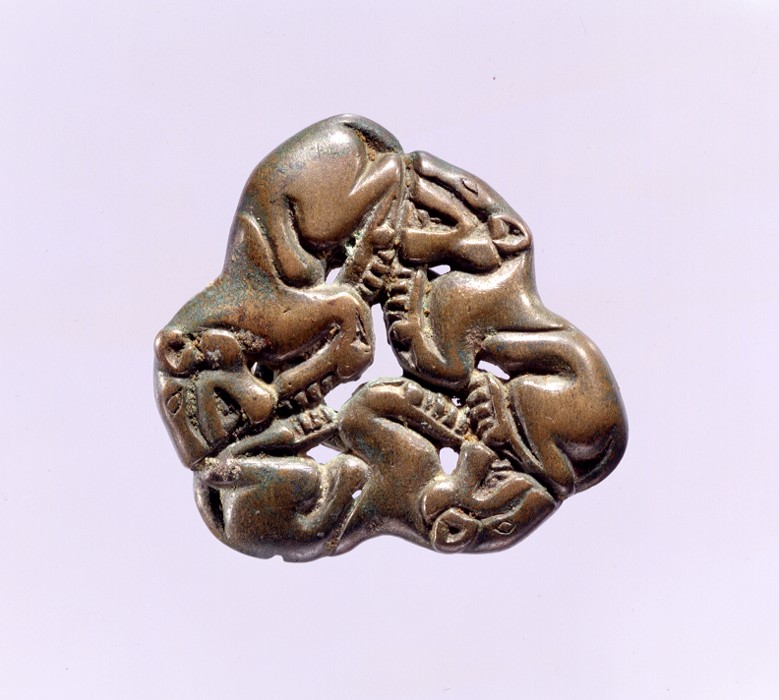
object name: strap crossing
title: Strap-Crossing in the Shape of Three Bears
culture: eastern eurasian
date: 500-401 BCE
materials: bronze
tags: bears